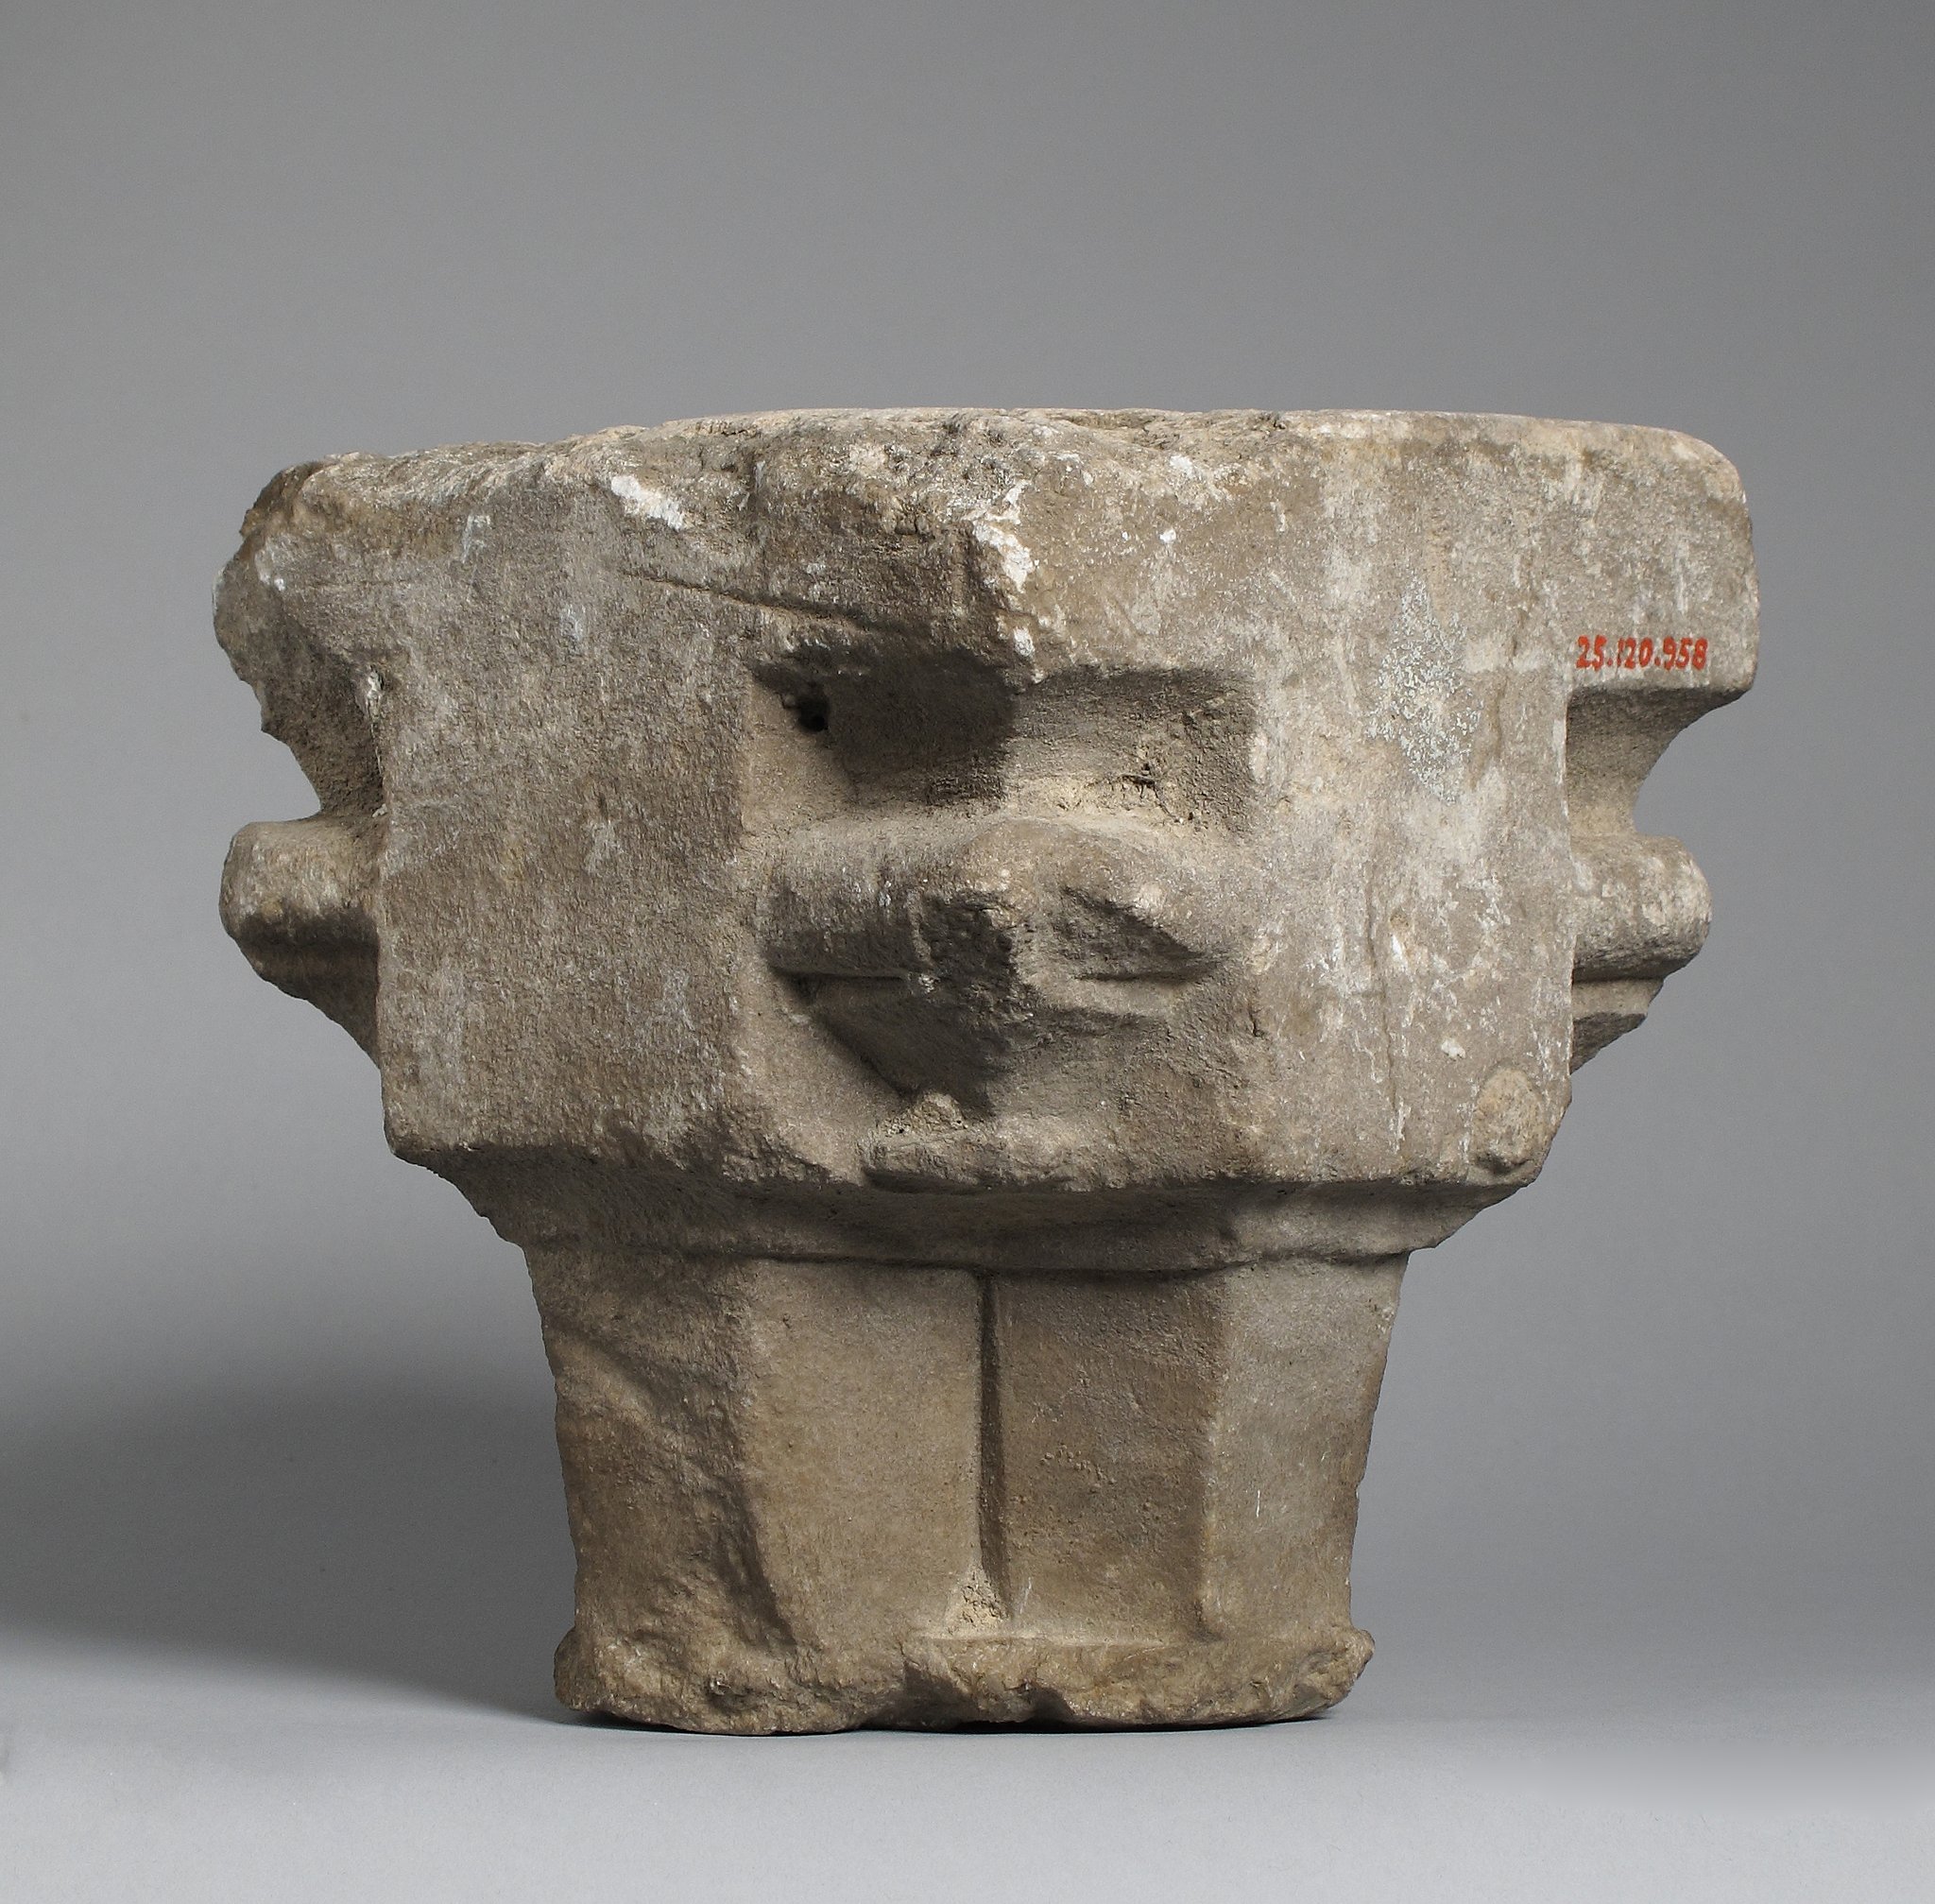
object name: capital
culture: french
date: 1301-1400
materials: stone